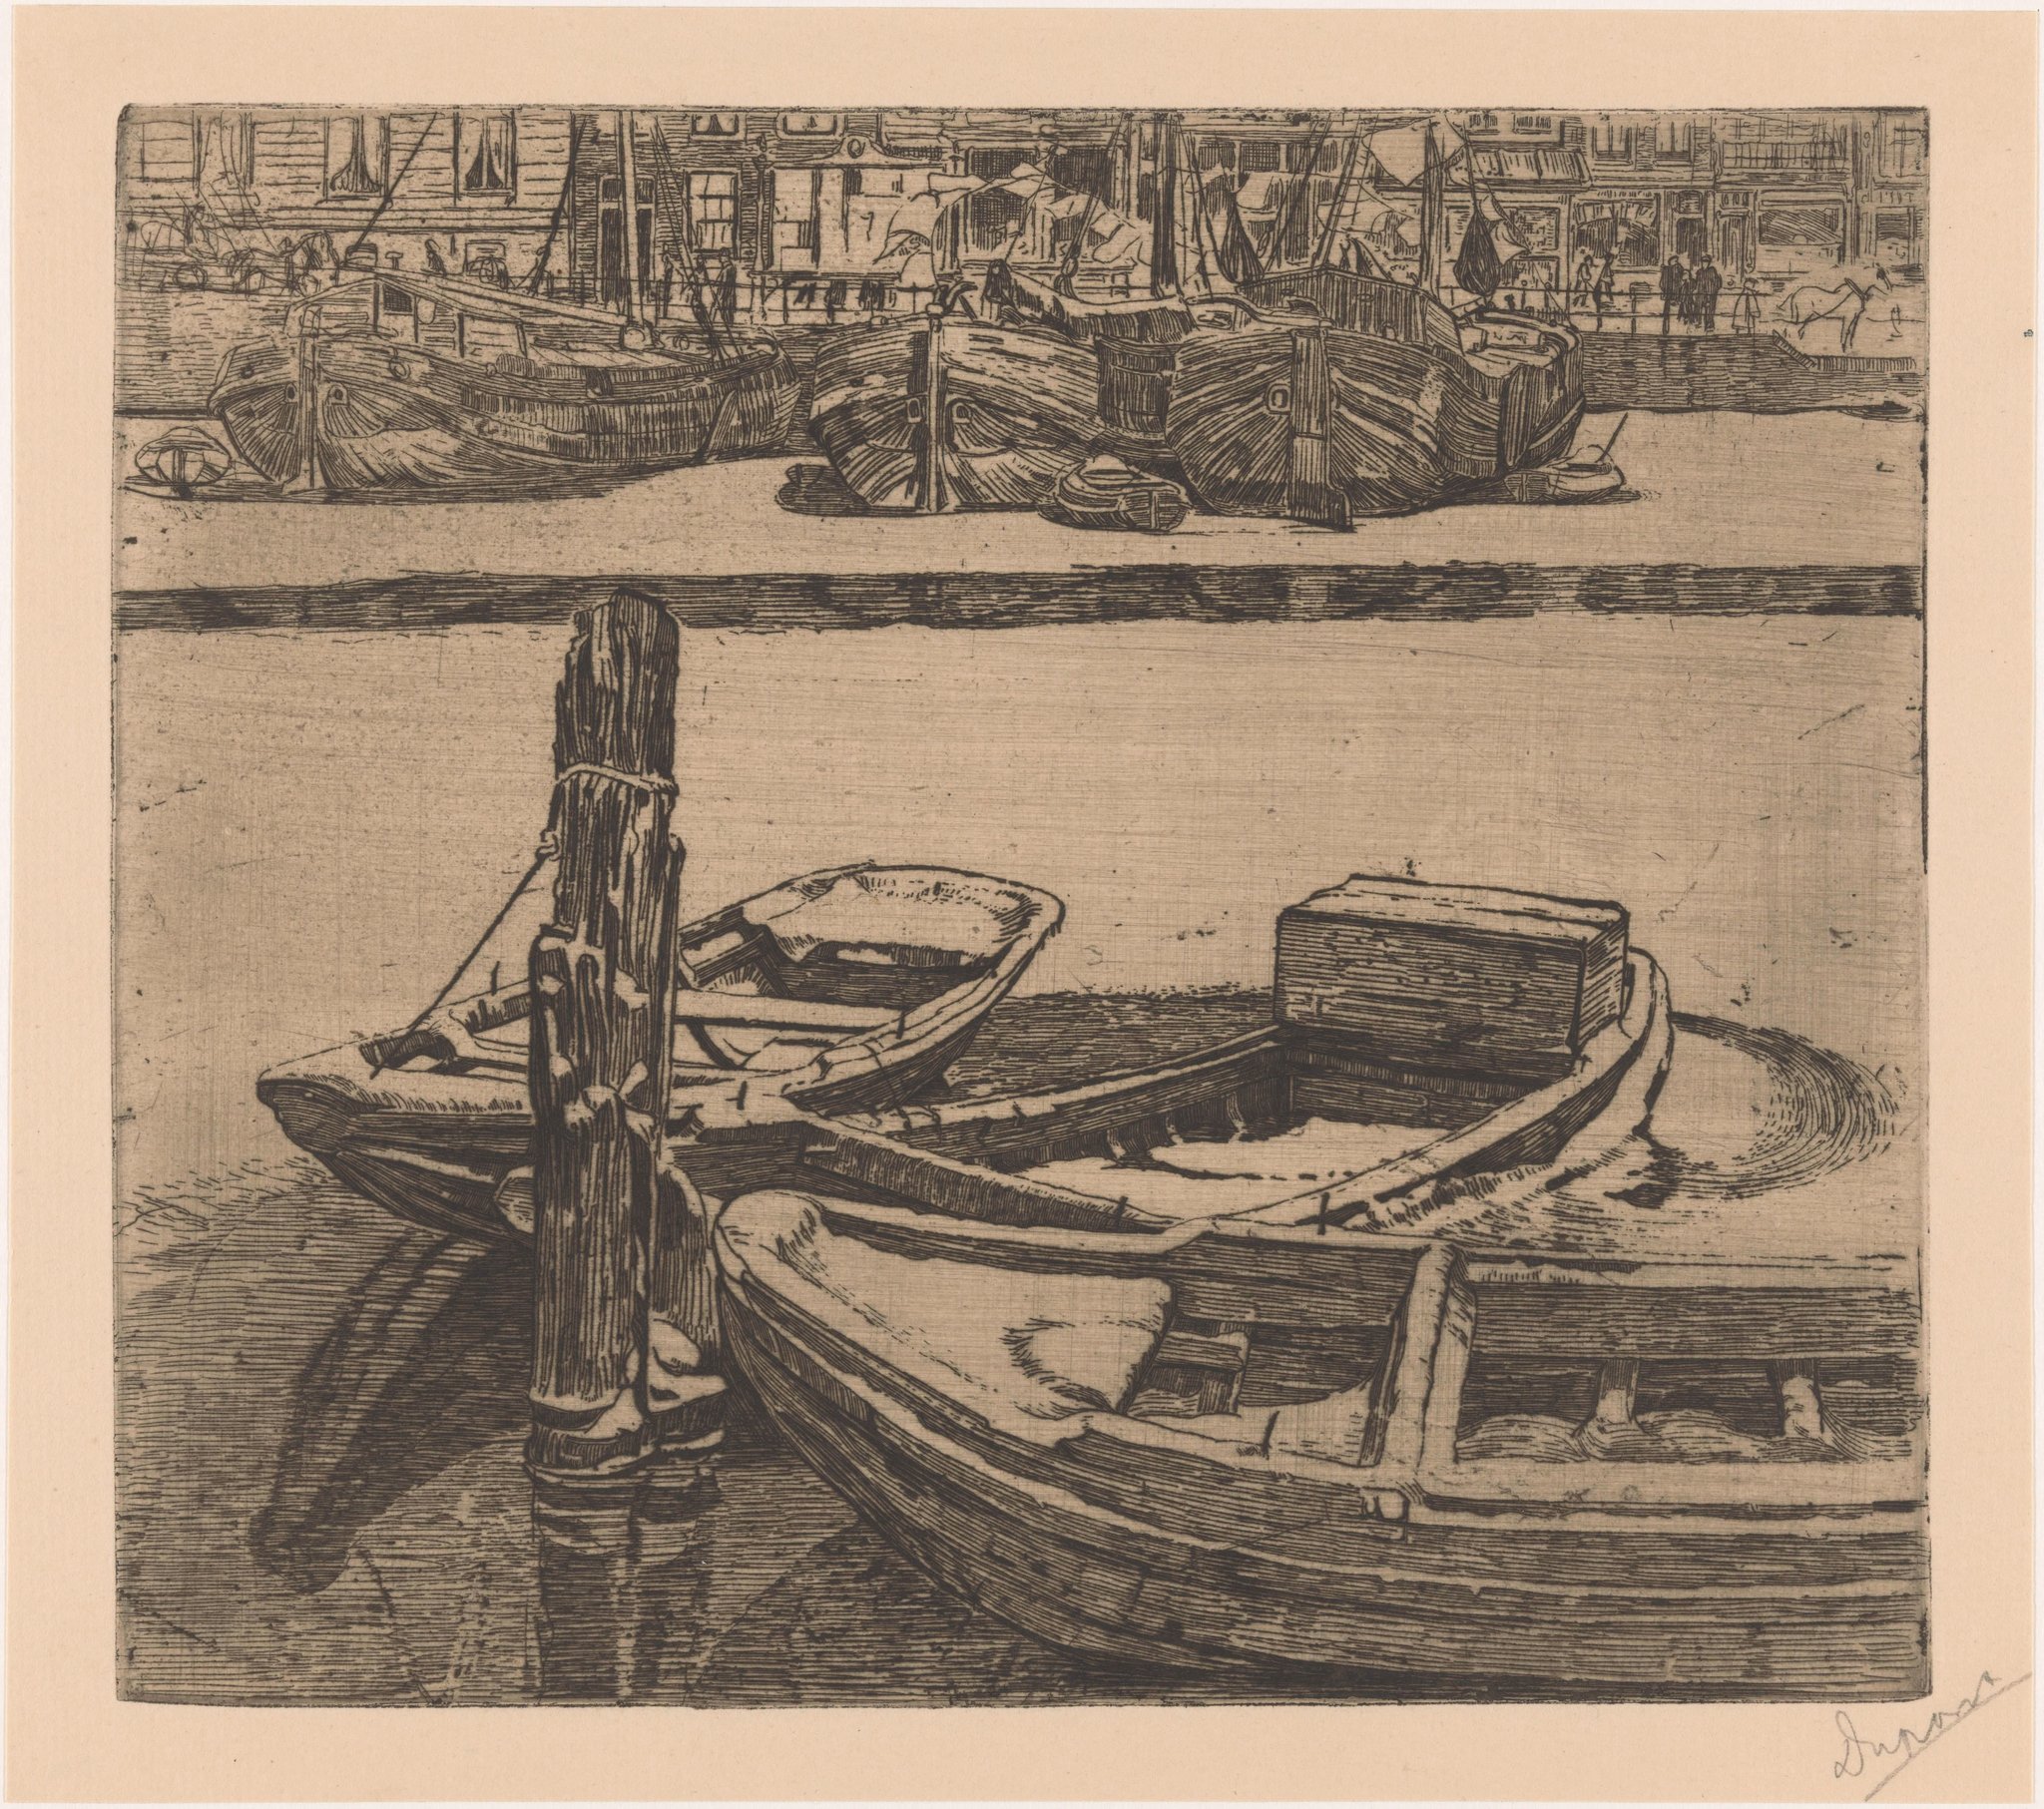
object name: print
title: Schepen in het Damrak in Amsterdam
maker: pieter dupont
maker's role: draughtsman, print maker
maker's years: 1870-1911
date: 1895-1896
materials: paper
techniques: intaglio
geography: amsterdam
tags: ships (in general), canals, waters (in city)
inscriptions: collector's mark: Lugt 2228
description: Op de voorgrond drie schuiten die afgemeerd zijn aan een meerpaal. Op de achtergrond afgemeerde tjalken aan de kade.